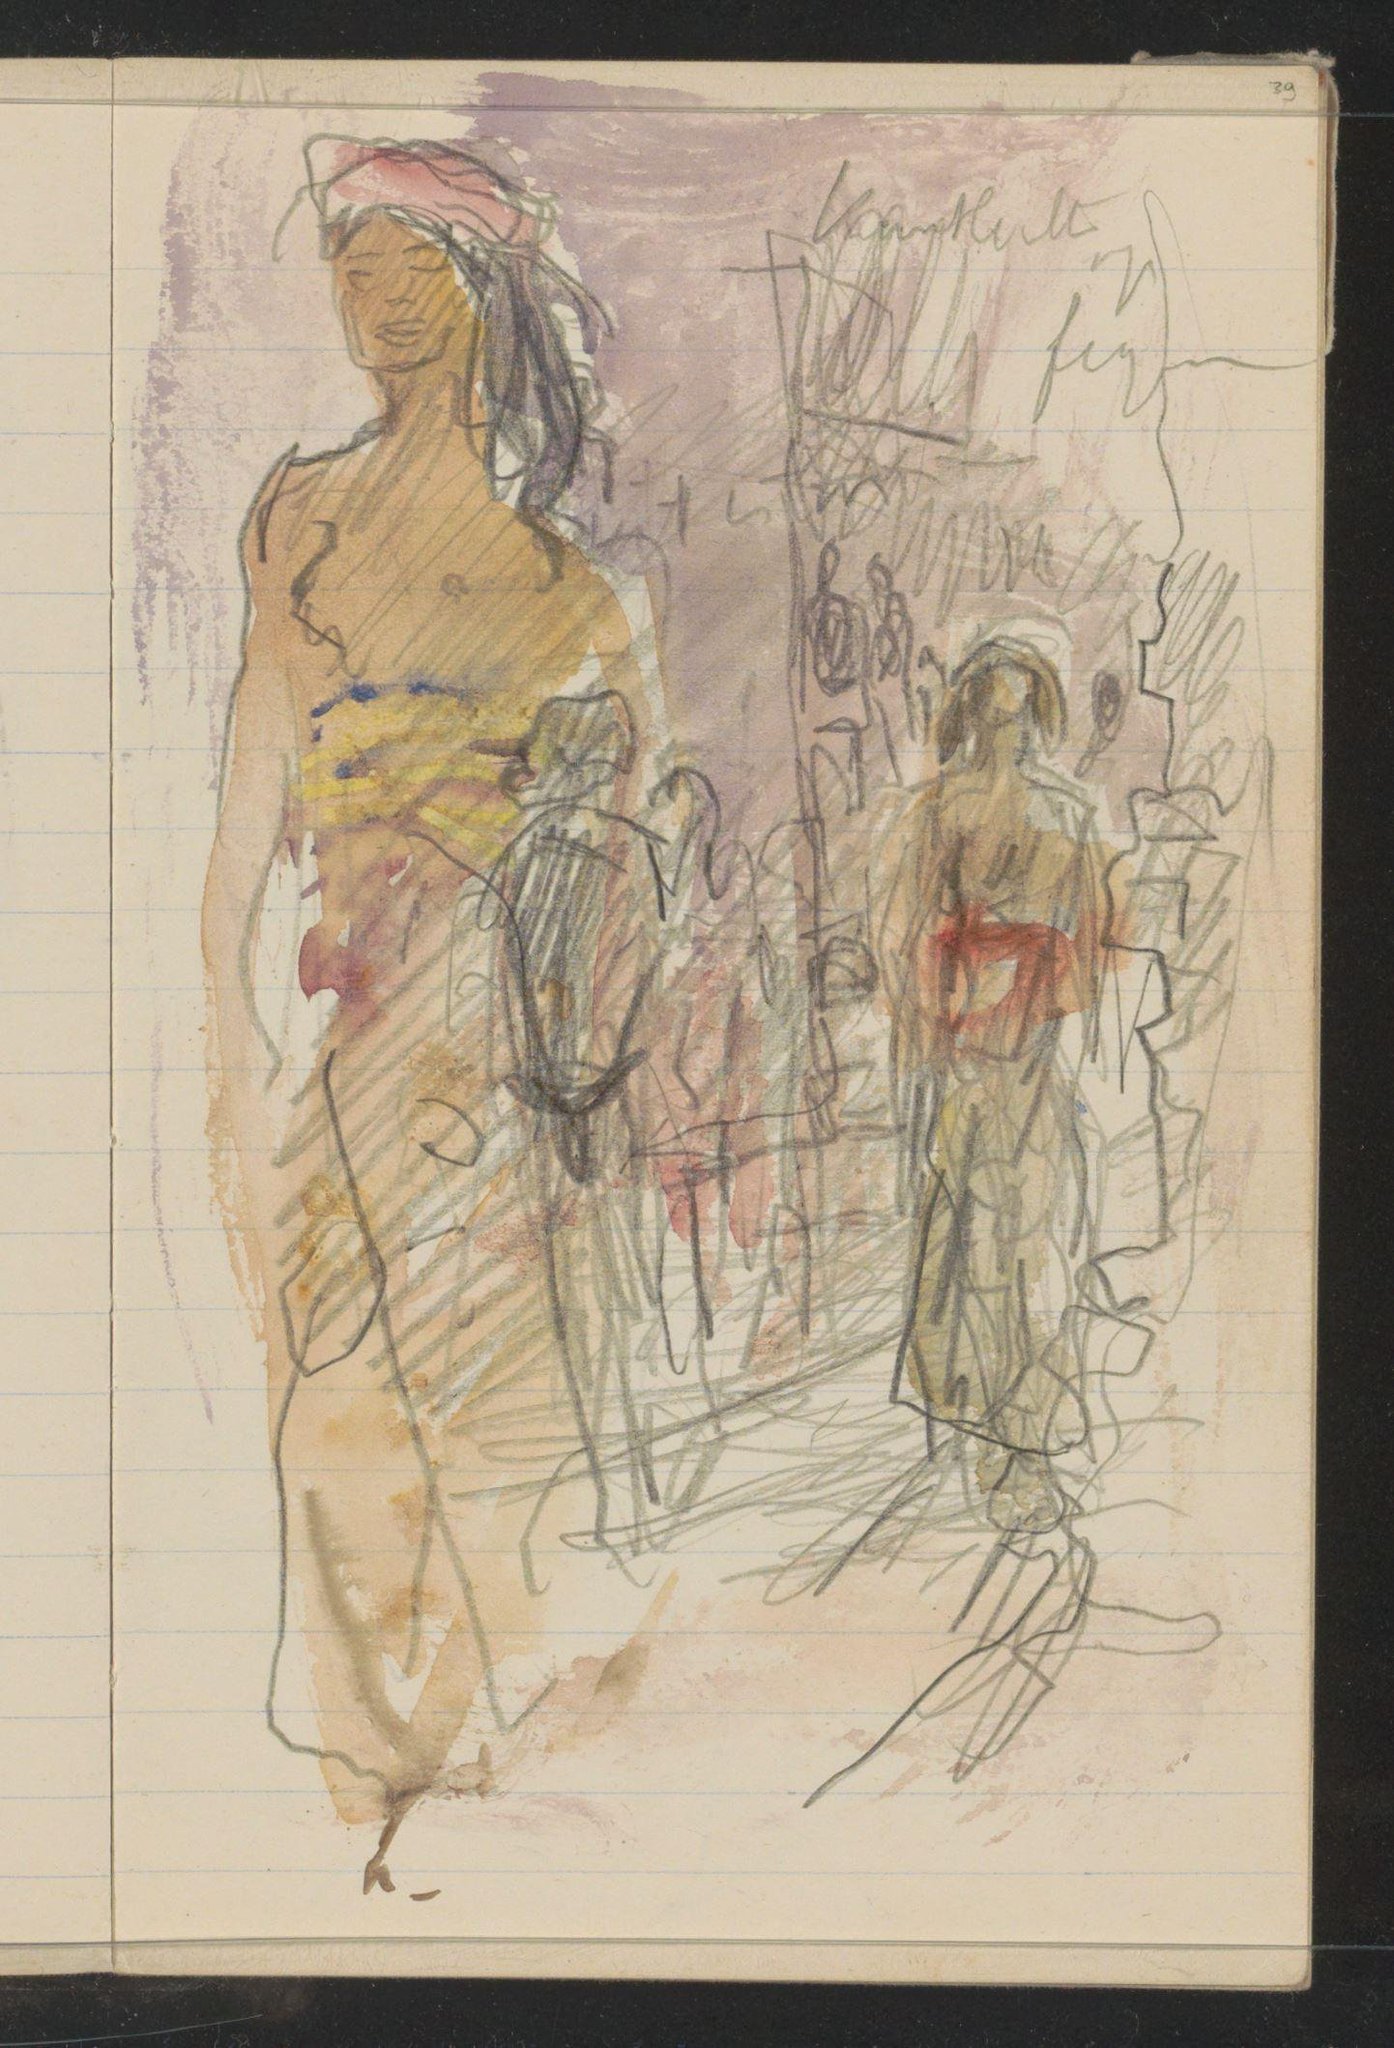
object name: sketchbook leaf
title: Straat met Indonesiërs in traditioneel kostuum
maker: marius bauer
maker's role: draughtsman, print maker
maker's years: 1867-1932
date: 1931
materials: pencil, watercolor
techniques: brush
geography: java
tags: asiatic races and peoples, folk costume, regional costume, street (+ city(-scape) with figures, staffage)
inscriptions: kleurnotitie, handgeschreven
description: Pagina 39 uit een schetsboek met 74 bladen.